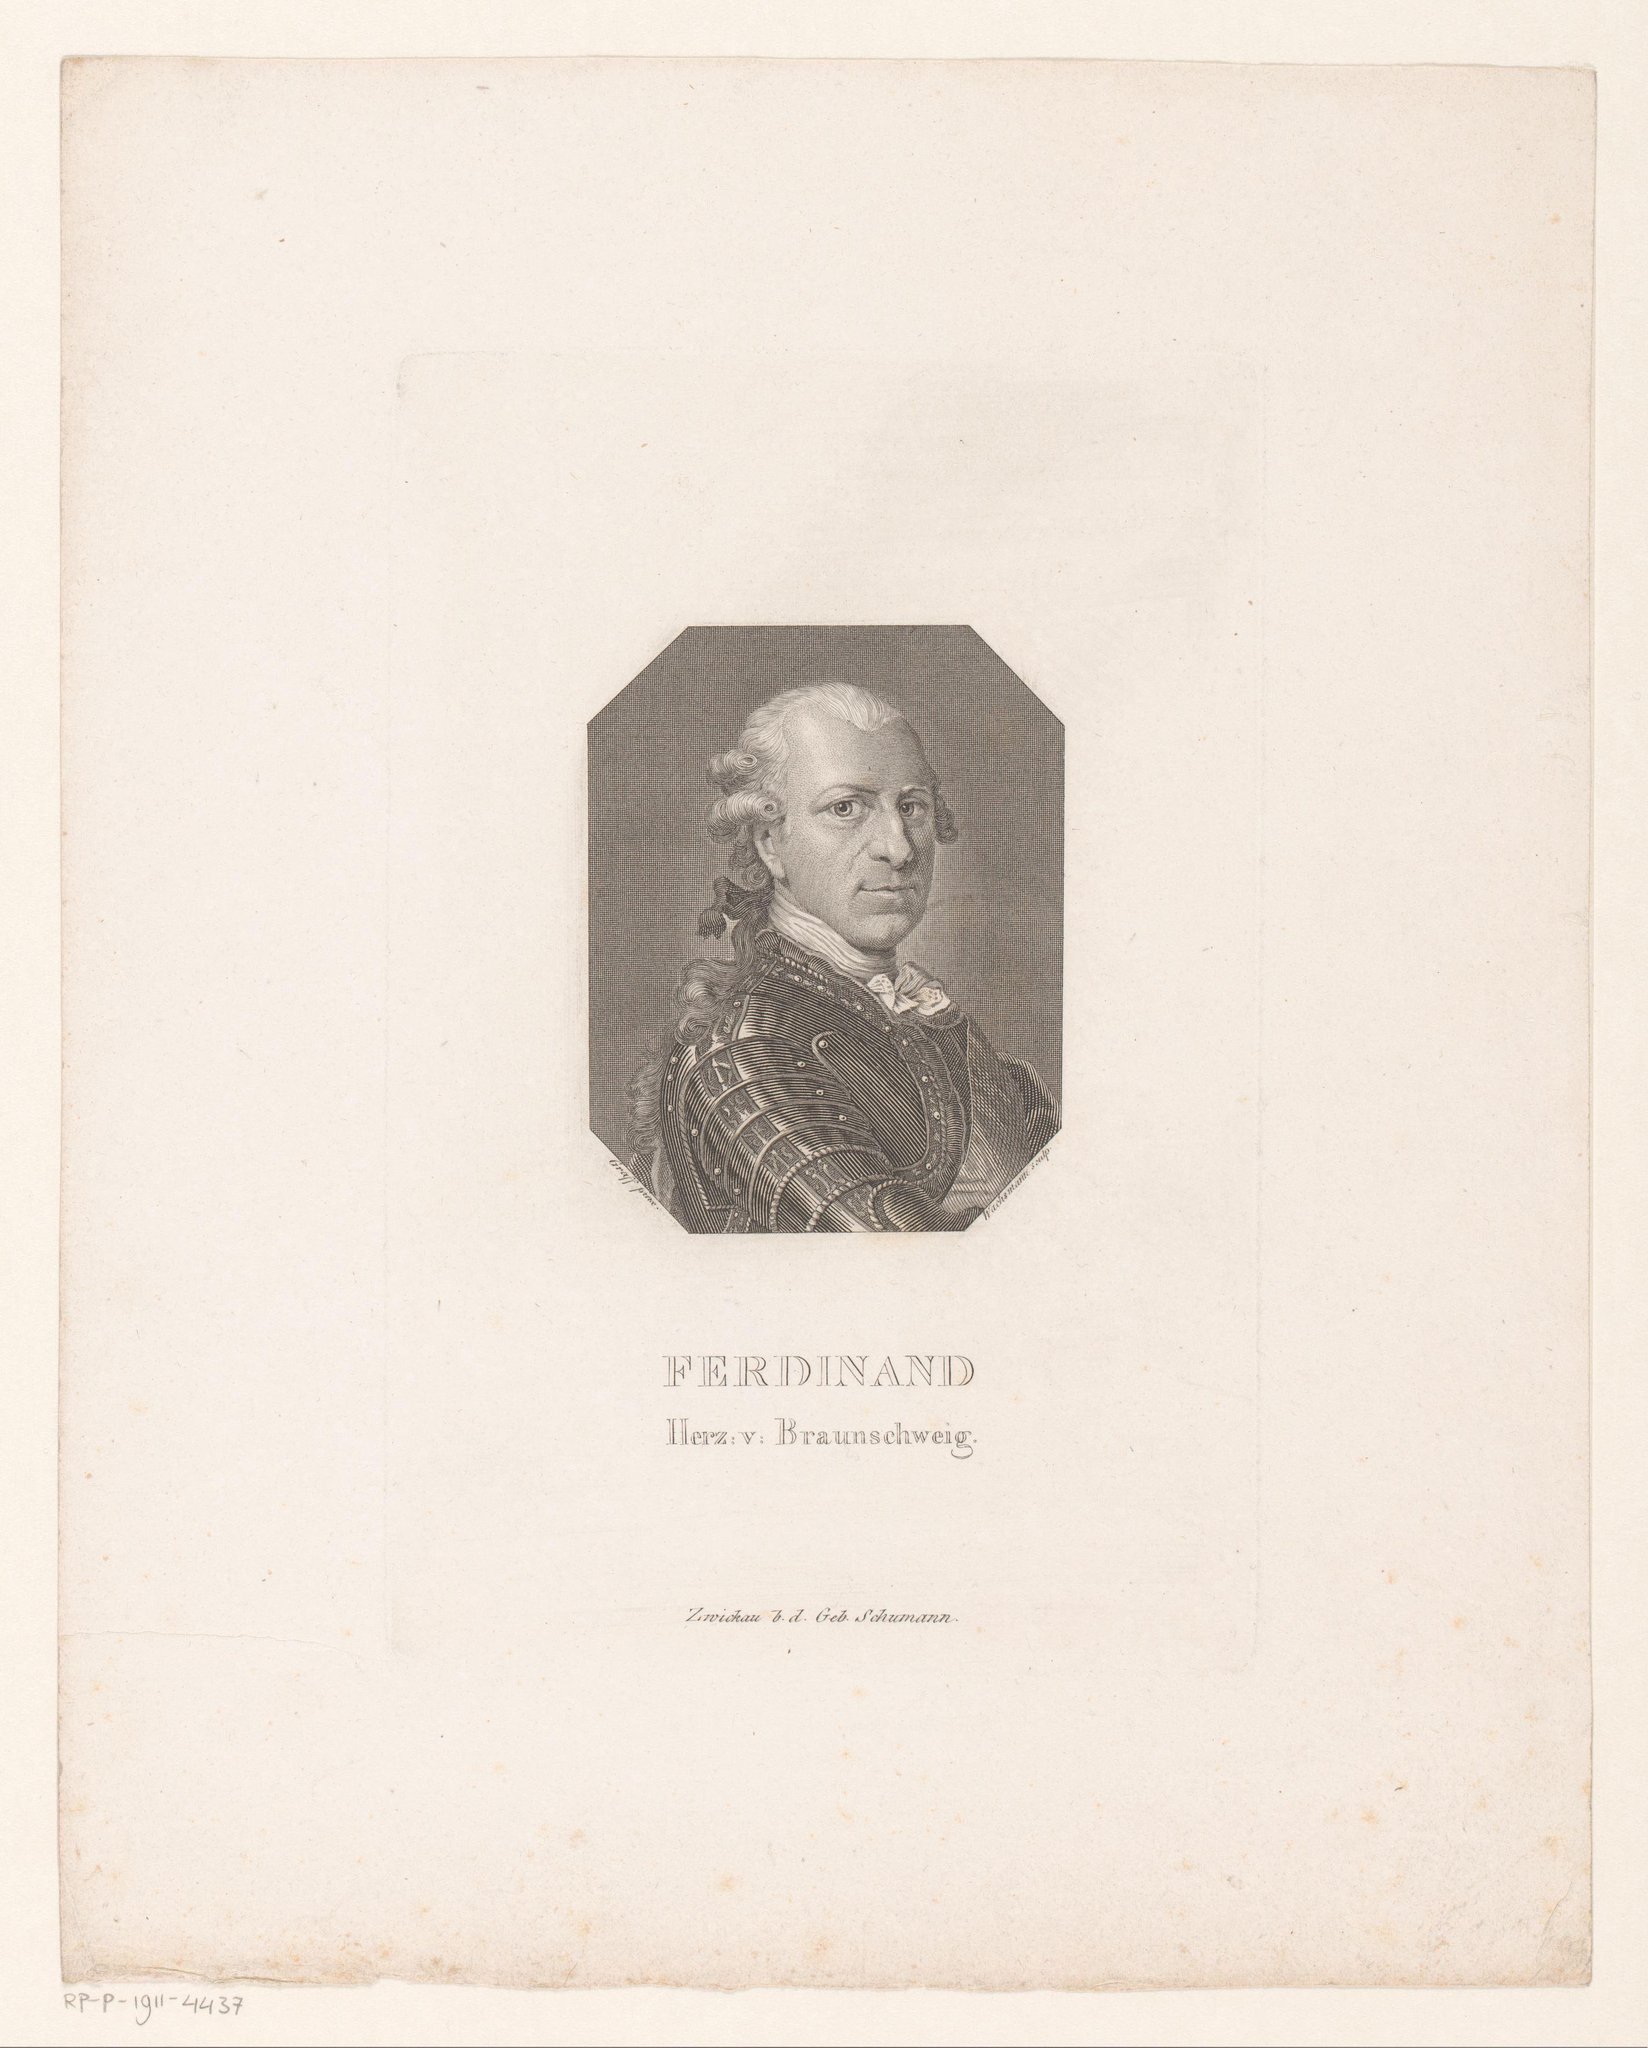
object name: print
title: Portretten van beroemde mensen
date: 1818-1832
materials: paper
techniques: engraving, etching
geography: germany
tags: historical persons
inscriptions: collector's mark: Lugt 2228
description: Prent gebruikt door de serie 'Bildnisse der berühmtesten Menschen aller Völker und Zeiten', uitgegeven door de gebroeders Schumann in 1818-1832 te Zwickau.